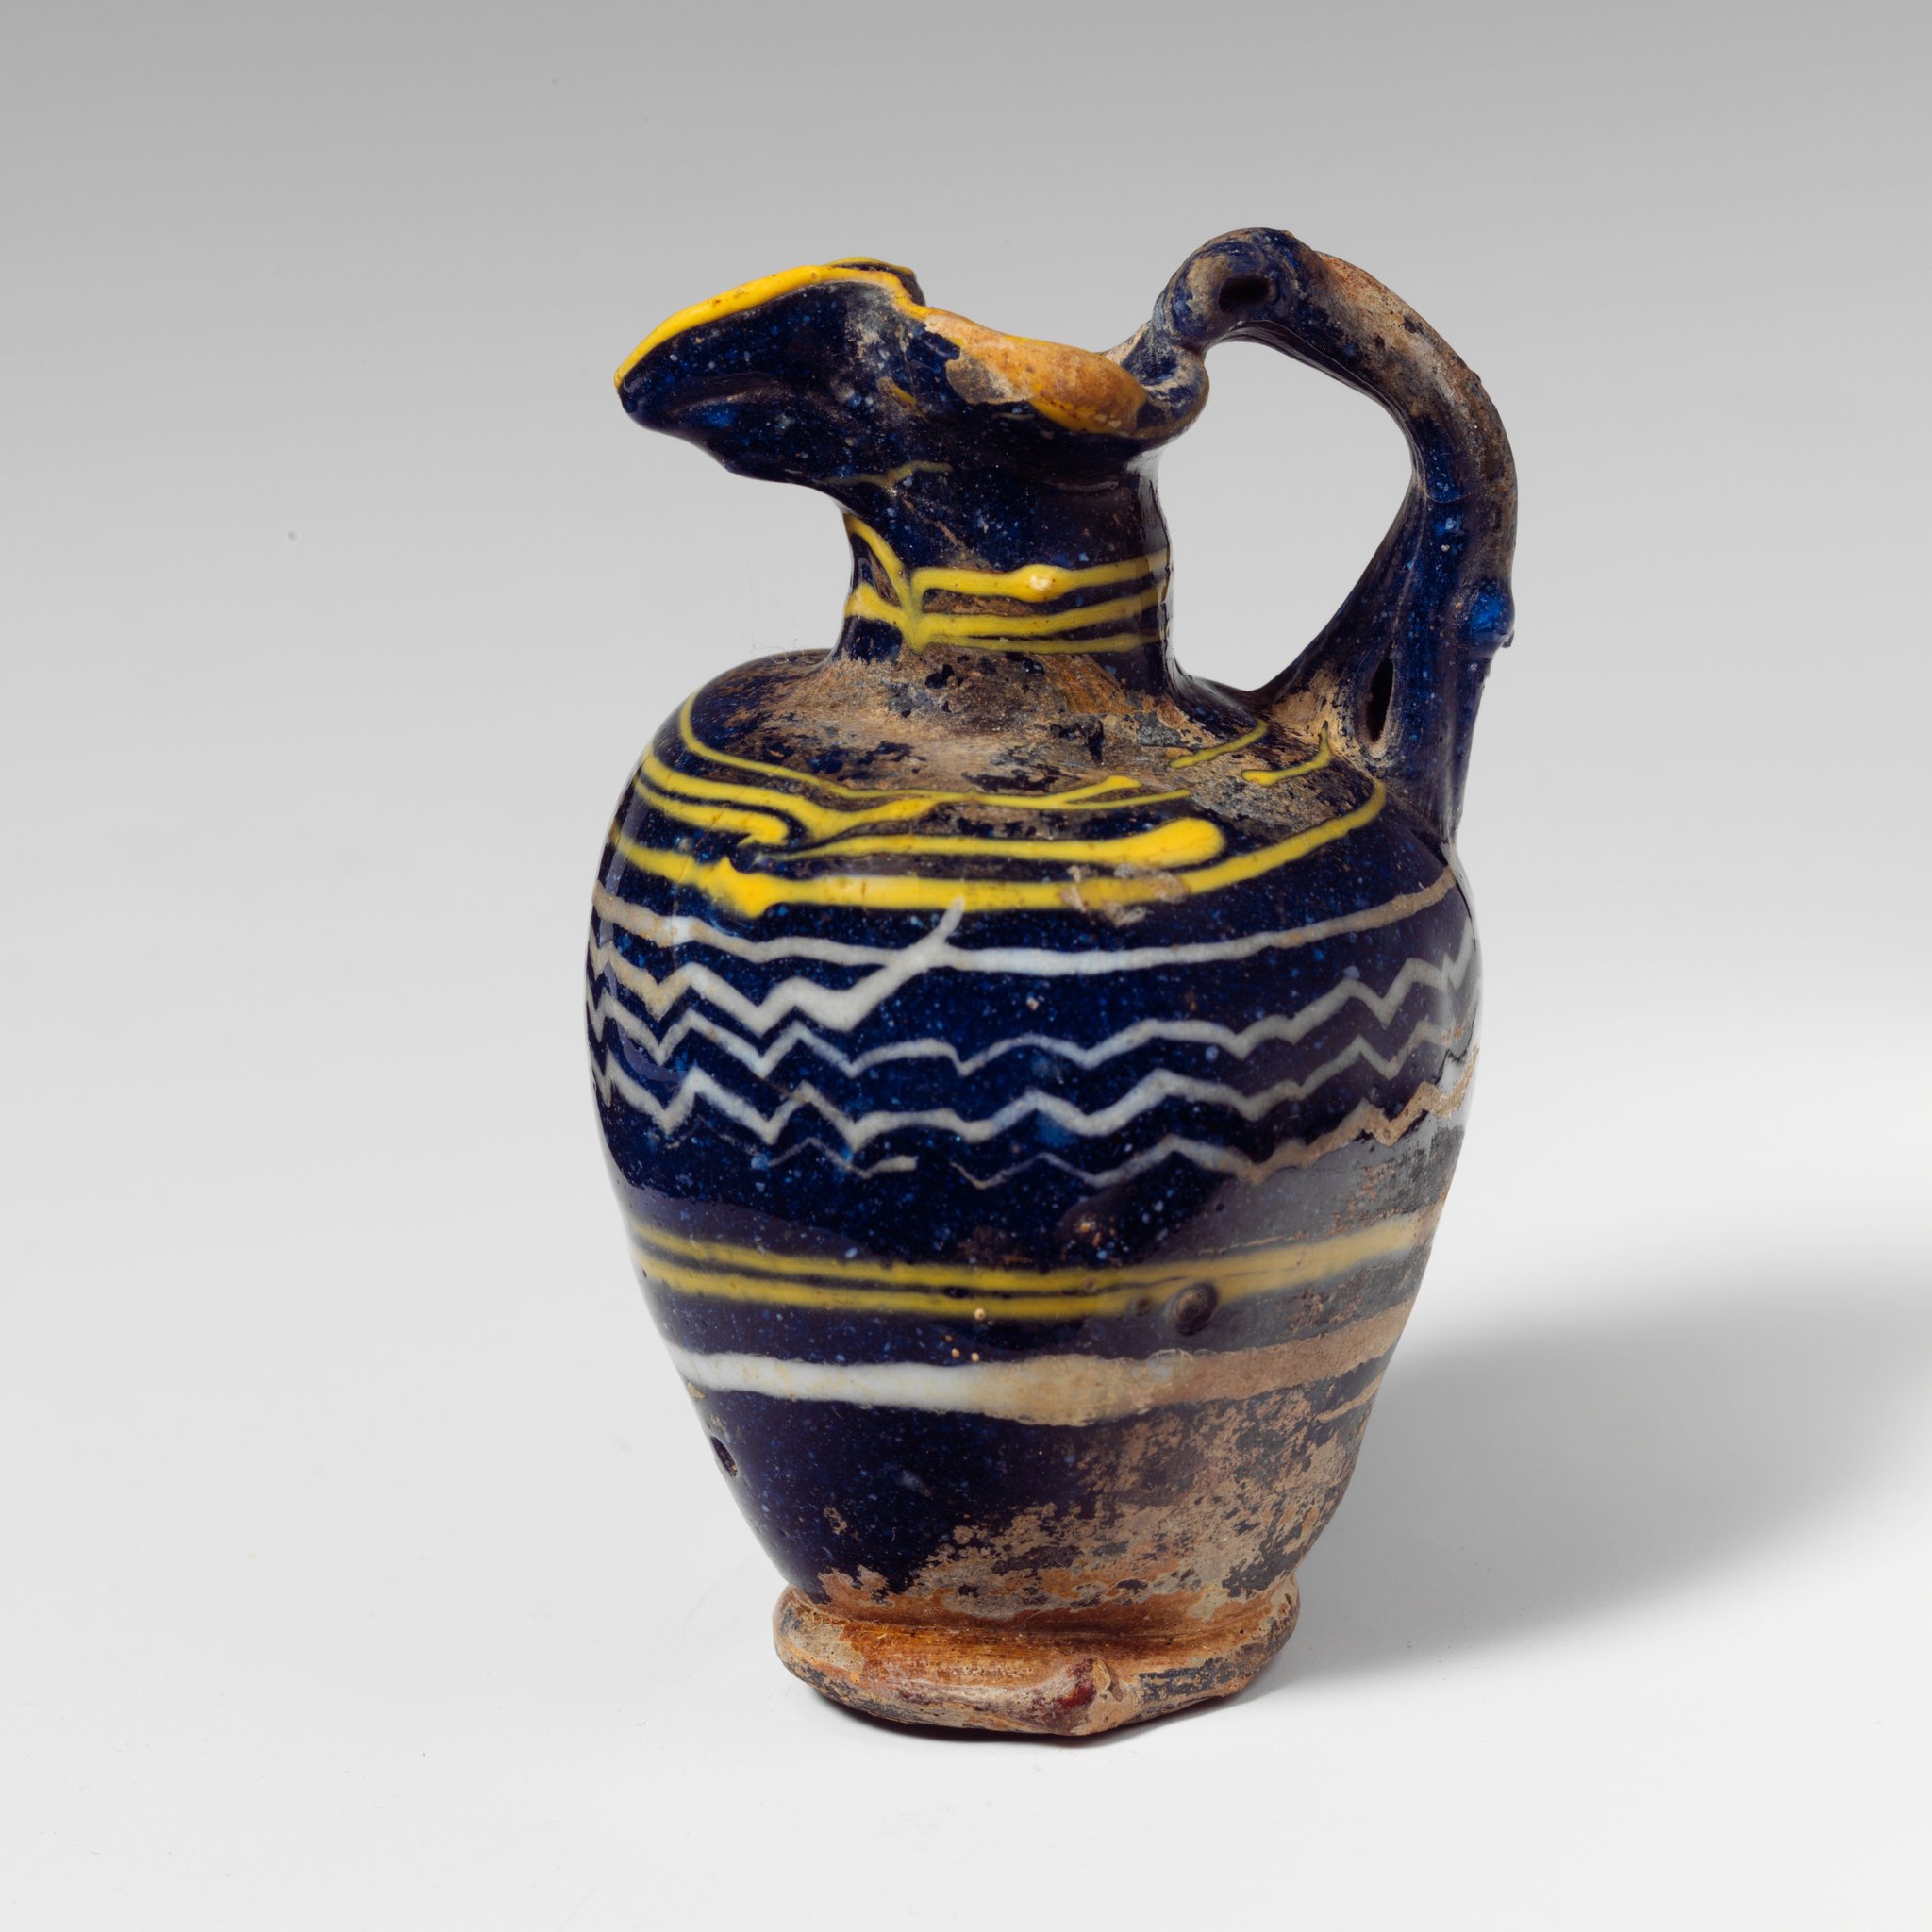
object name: oinochoe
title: Glass oinochoe (perfume jug)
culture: greek or eastern mediterranean or italian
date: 400-201 BCE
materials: glass